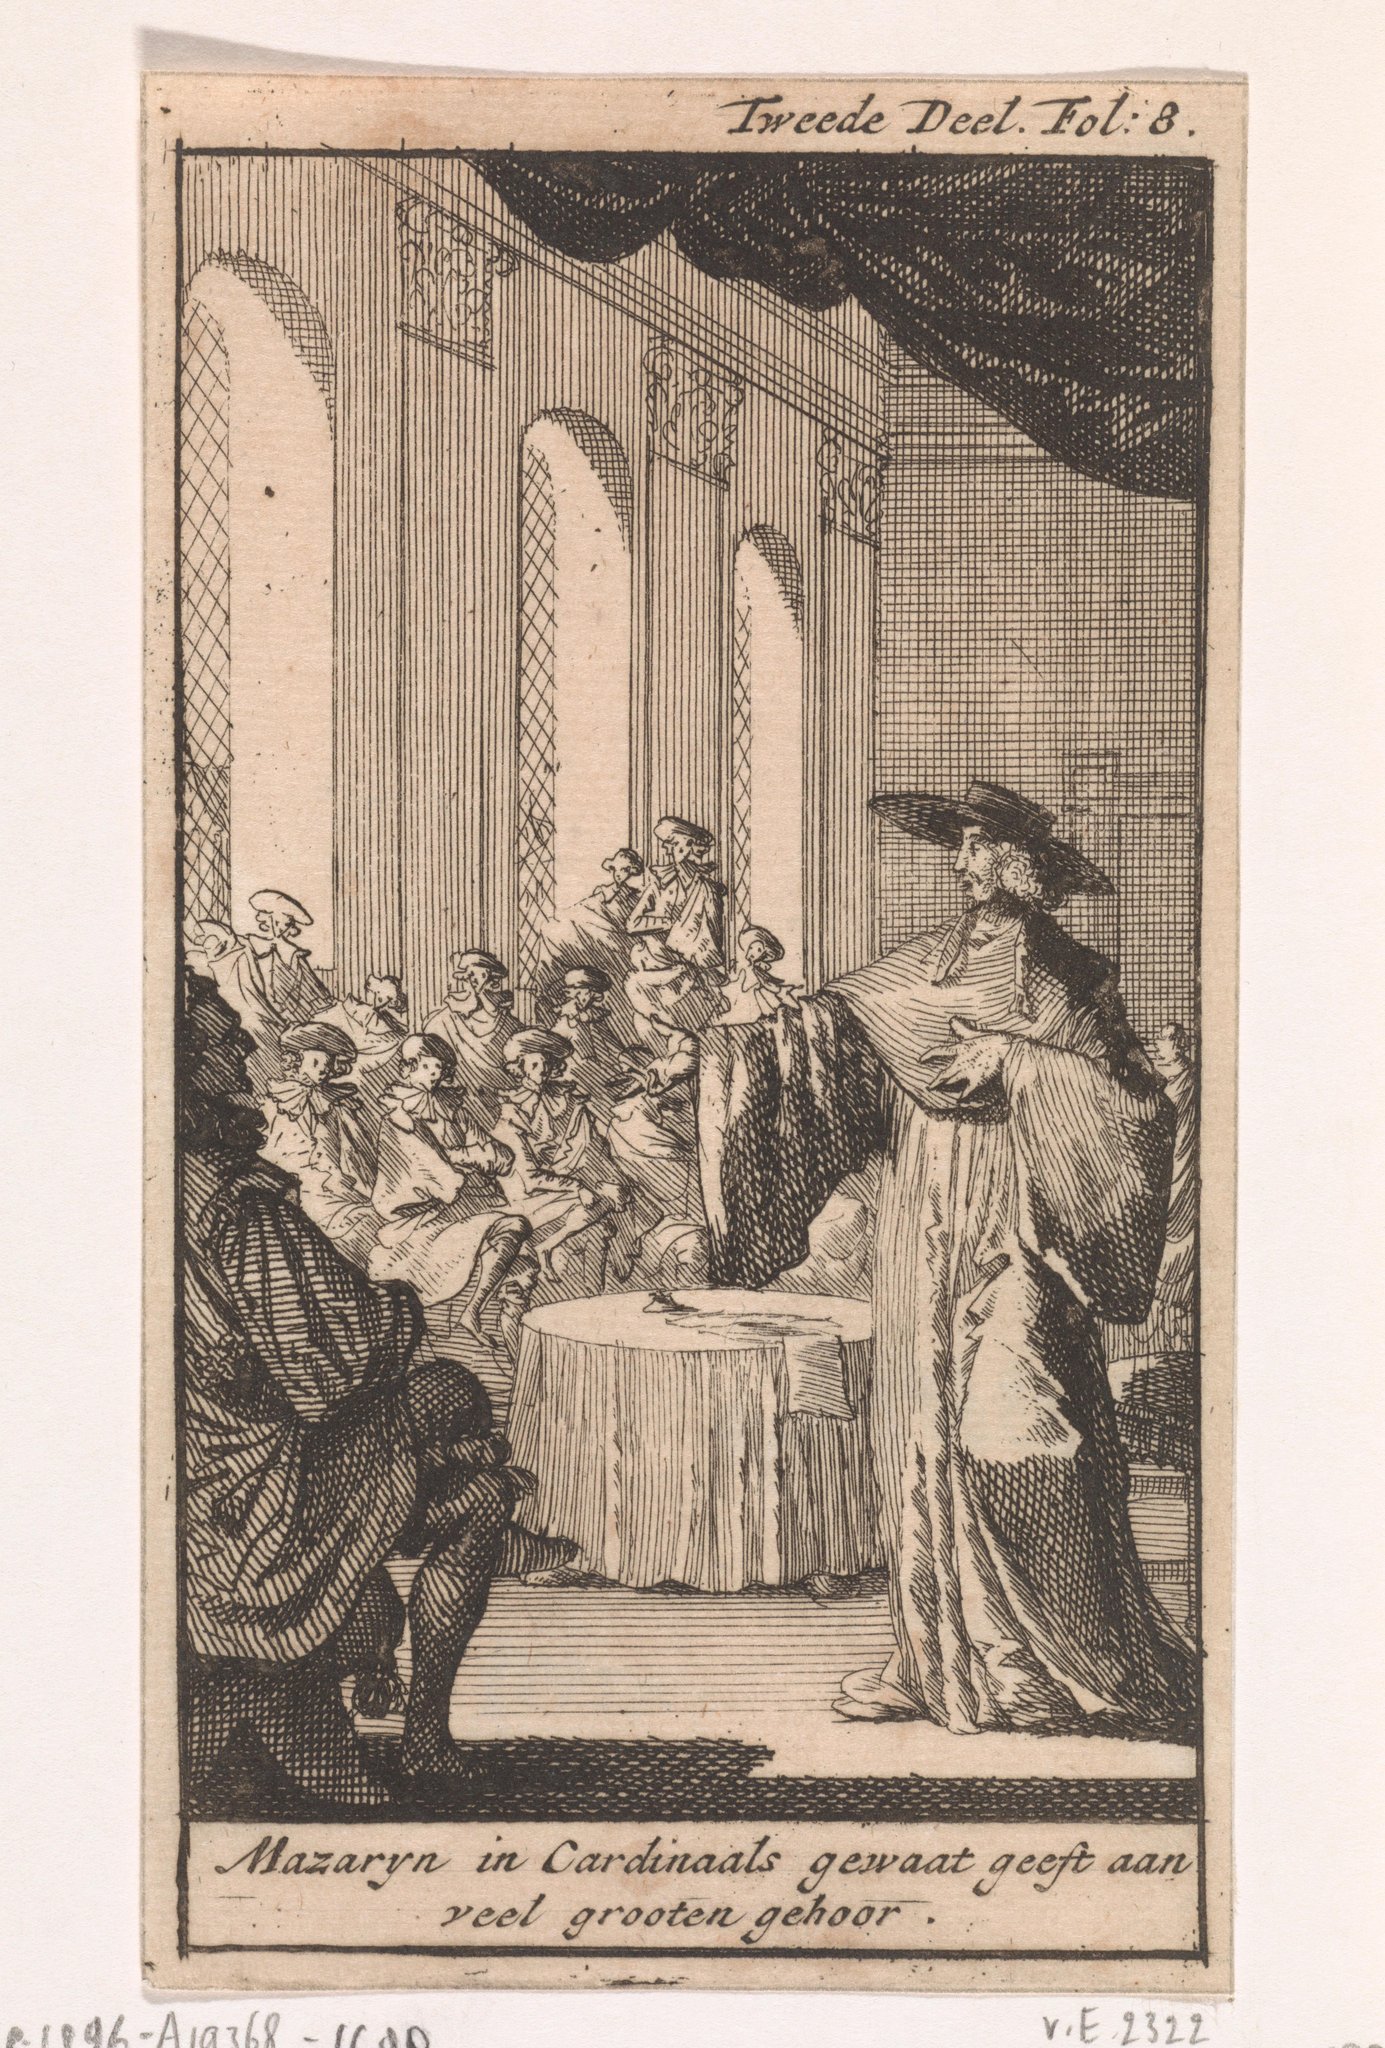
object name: book illustration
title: Kardinaal Mazarin verdedigt zich in een statenvergadering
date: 1699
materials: paper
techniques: etching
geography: leiden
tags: jules mazarin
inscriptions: collector's mark: Lugt 2228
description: Boekillustratie voor Het leven en bedryf van den wytberoemden en grooten staatkundigen Julius Mazaryn. Leiden: Boudewijn van der Aa, 1699, dl. 2, f. 8.